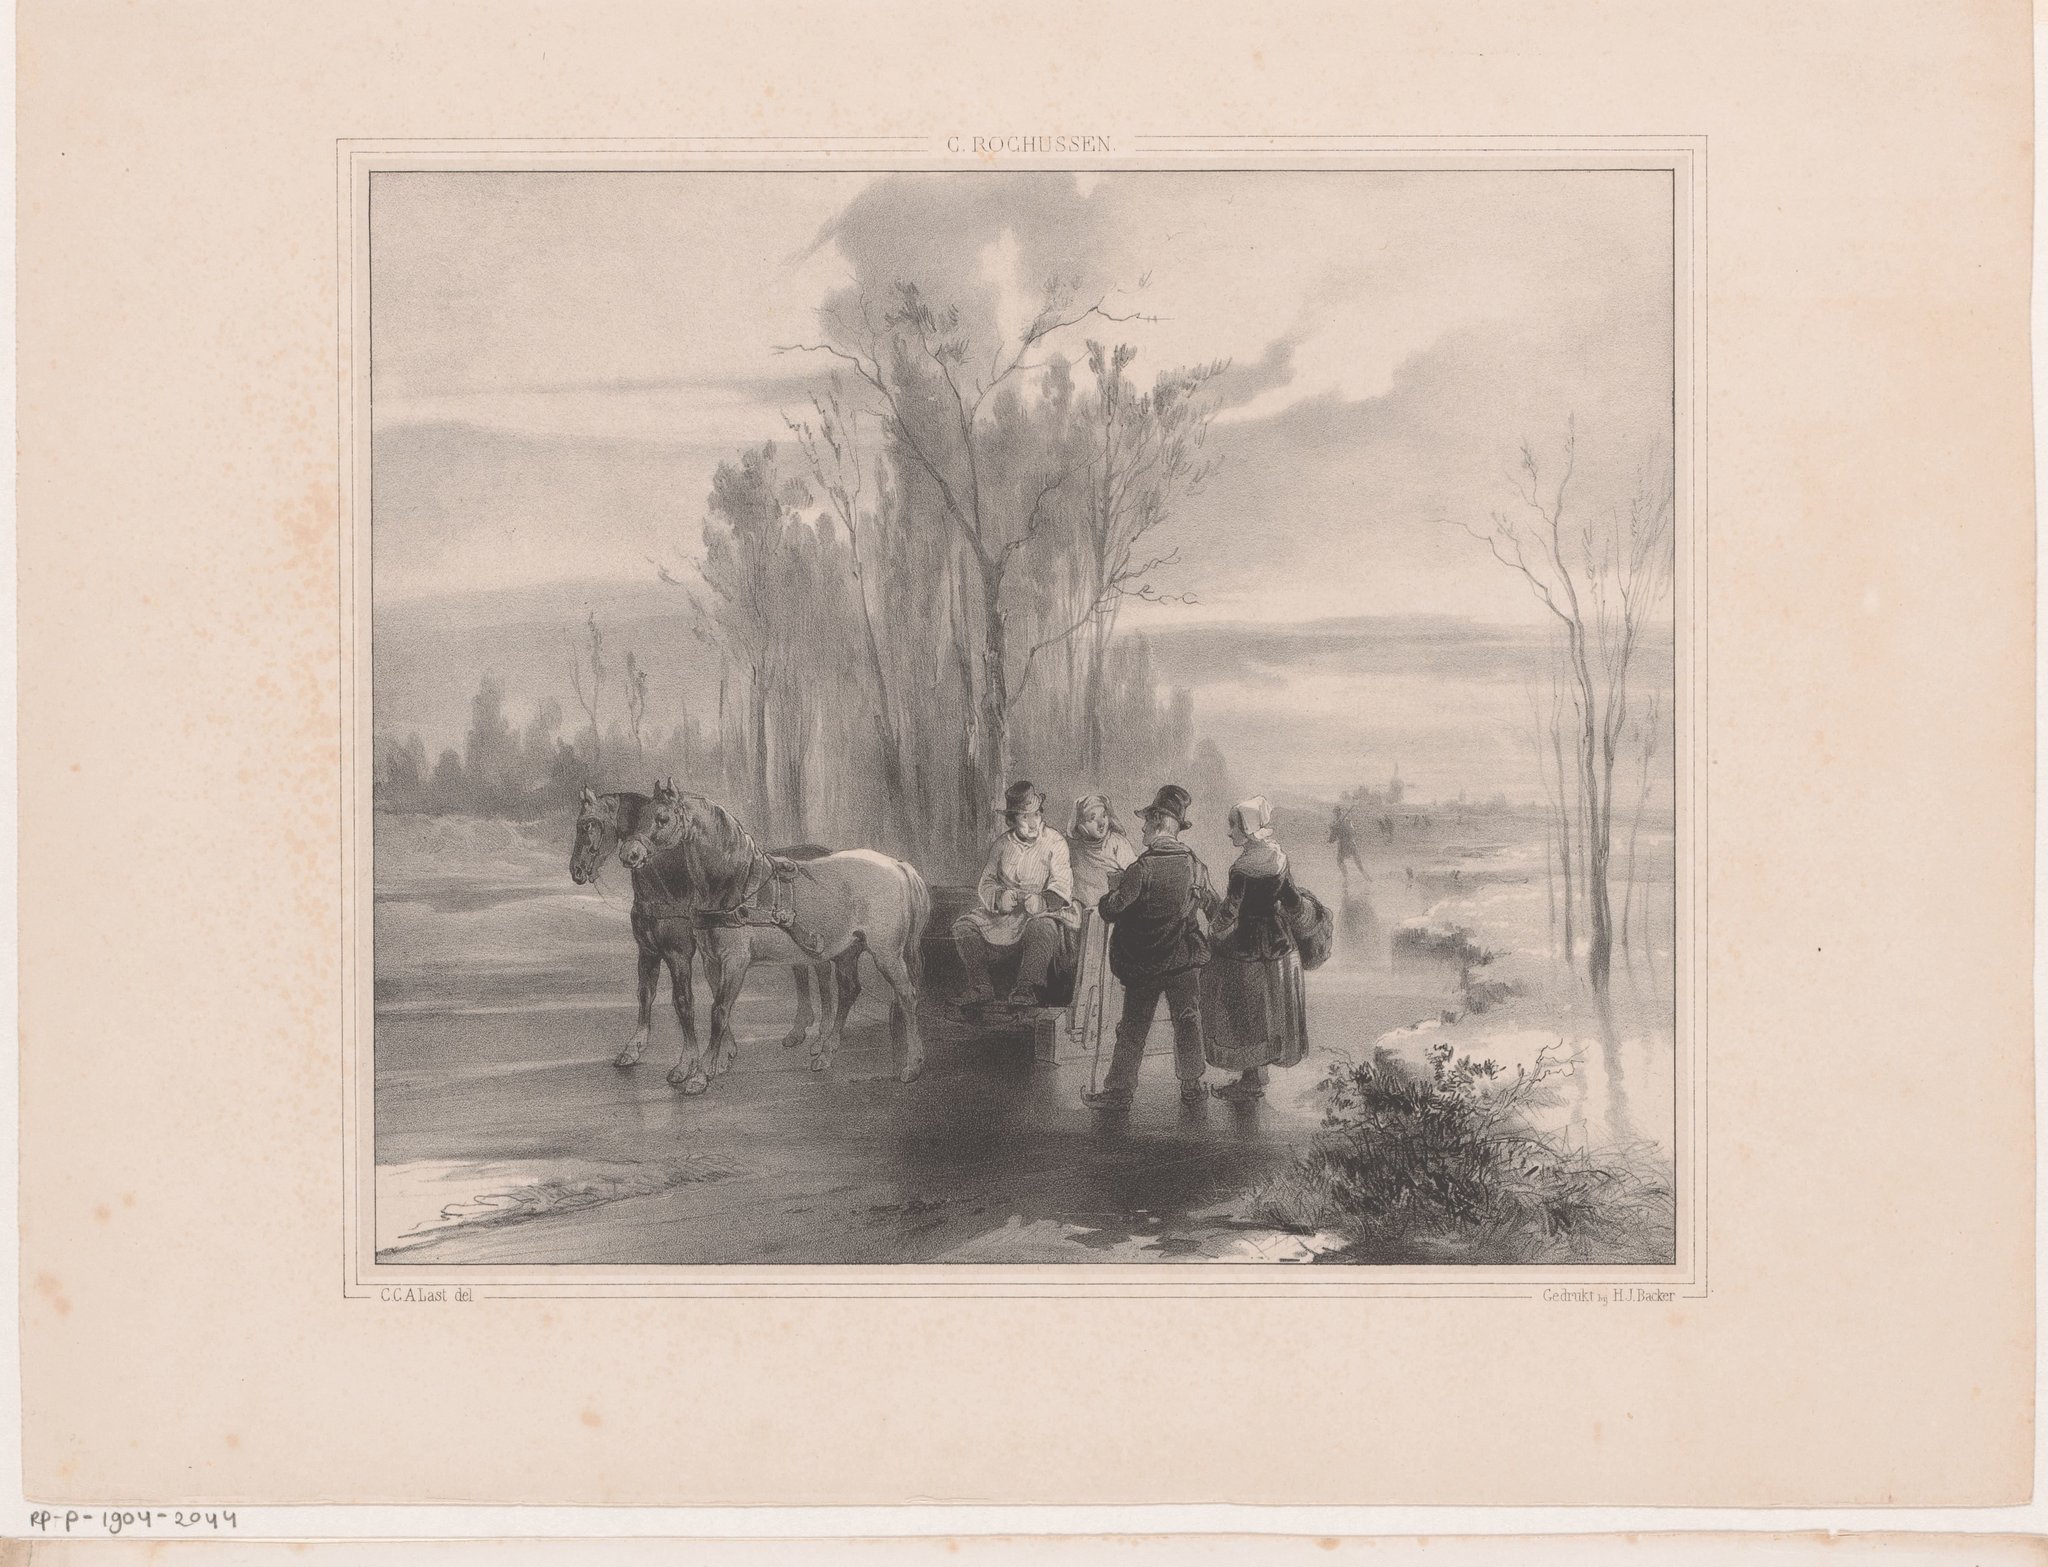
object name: print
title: Ontmoeting op het ijs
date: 1822-1845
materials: paper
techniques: lithograph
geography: dordrecht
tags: frost, freezing weather, horse-sleigh, skates (winter sports), meeting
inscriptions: collector's mark: Lugt 2228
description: Een man en vrouw, gezeten op een slede met twee paarden ervoor, zijn in gesprek met een man en vrouw op schaatsen.